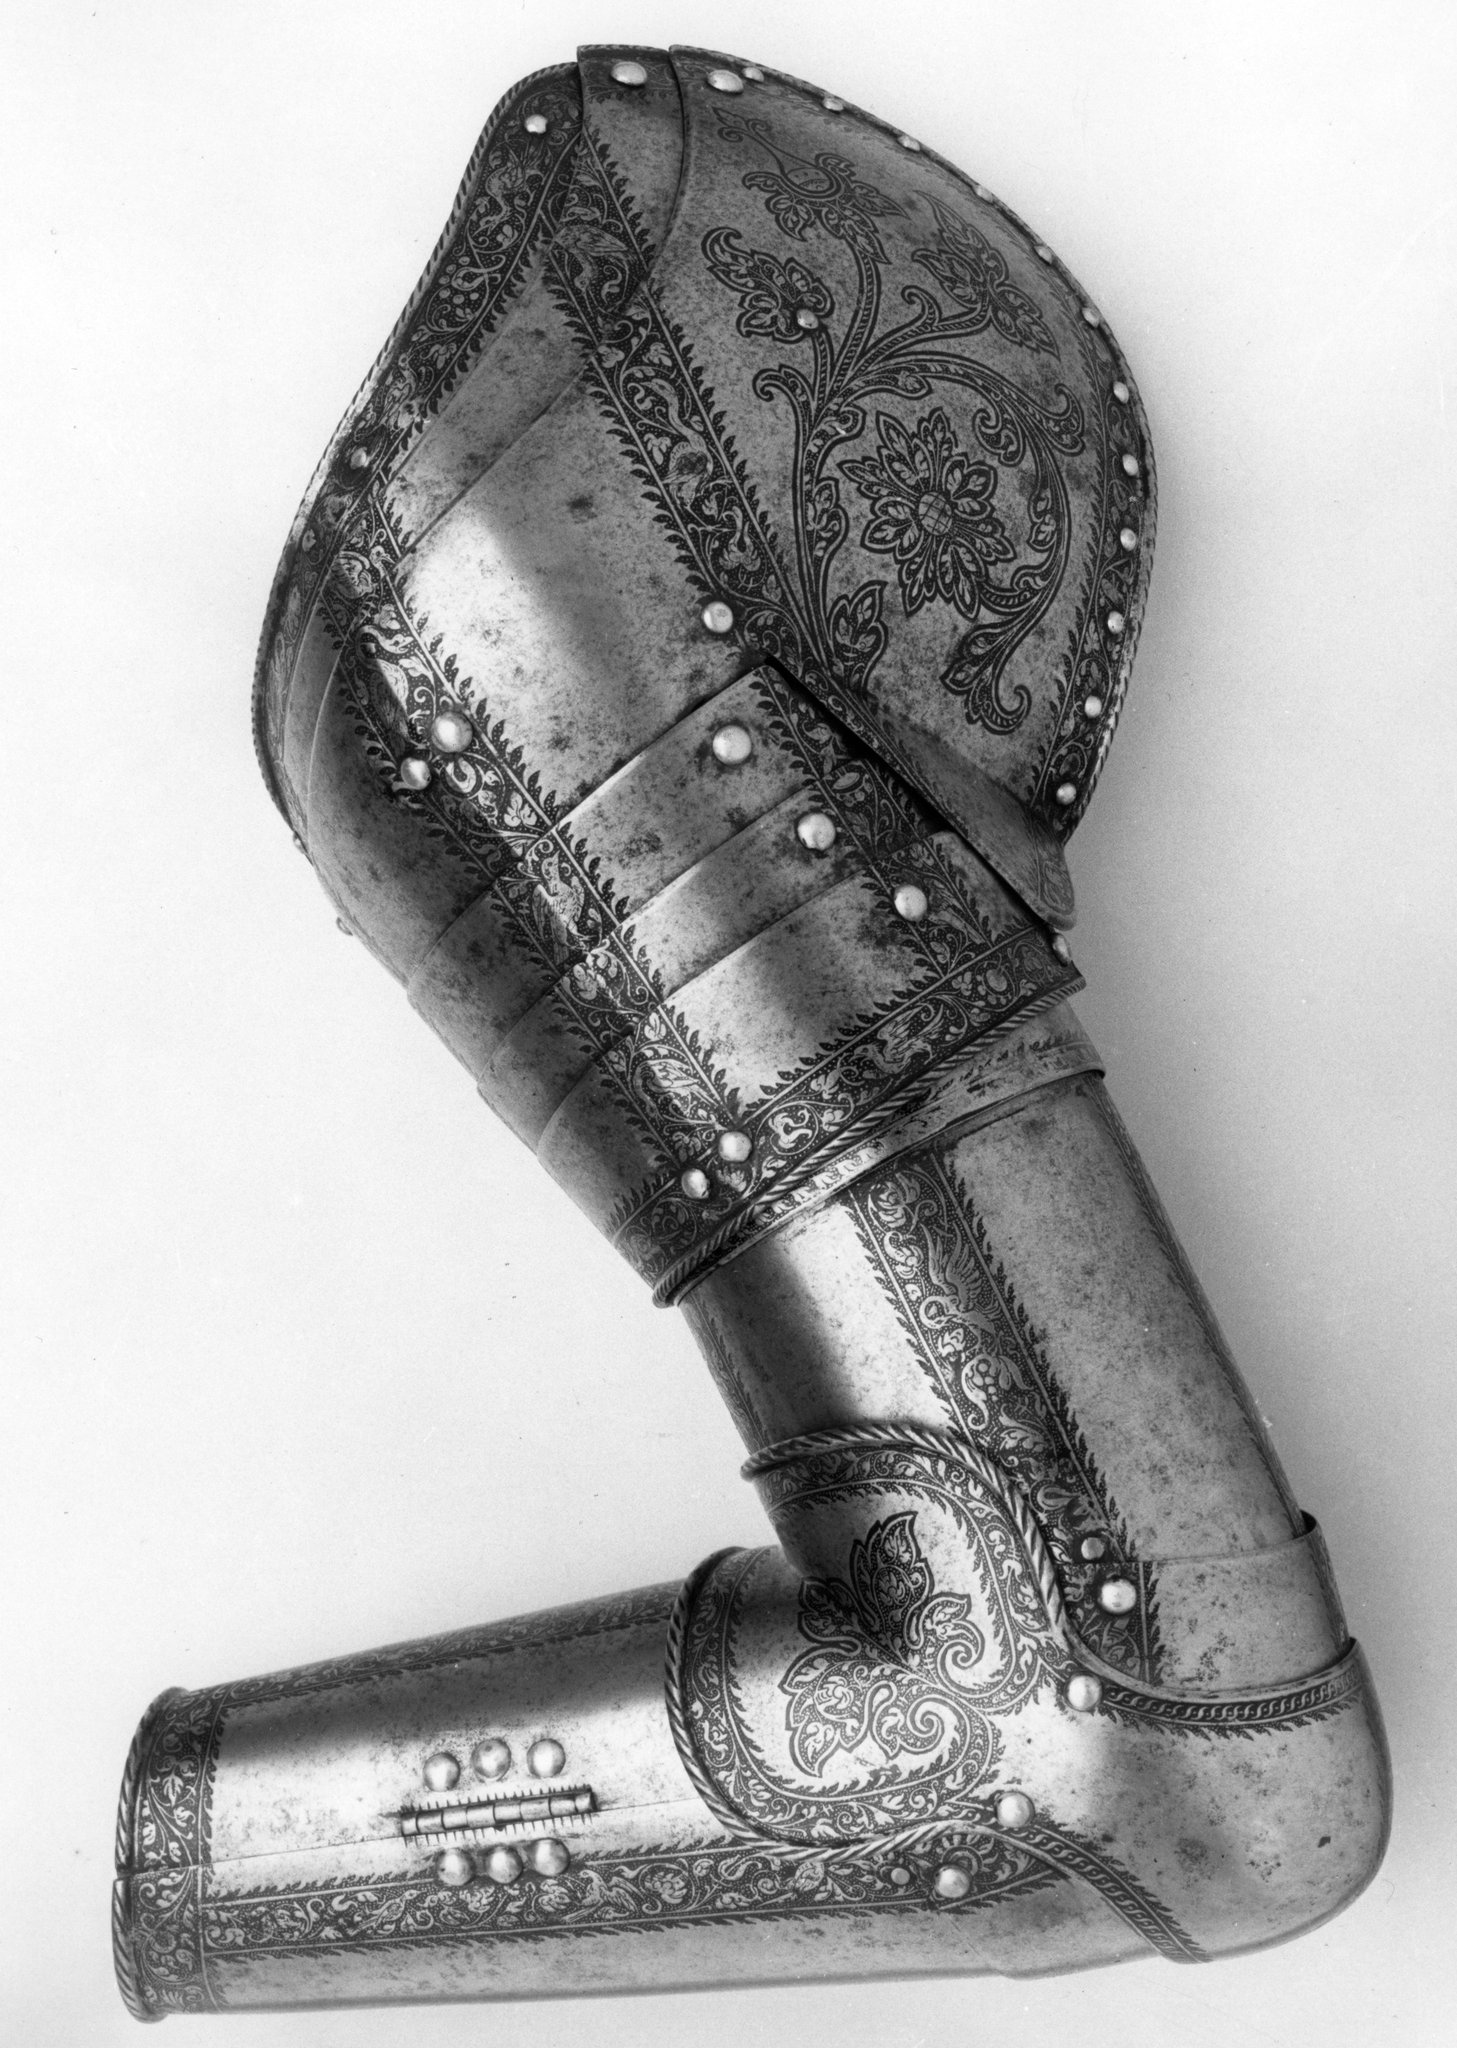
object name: left shoulder and arm defense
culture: german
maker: wolfgang grosschedel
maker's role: armorer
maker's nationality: german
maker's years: 1517-1562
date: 1555-1560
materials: steel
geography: germany